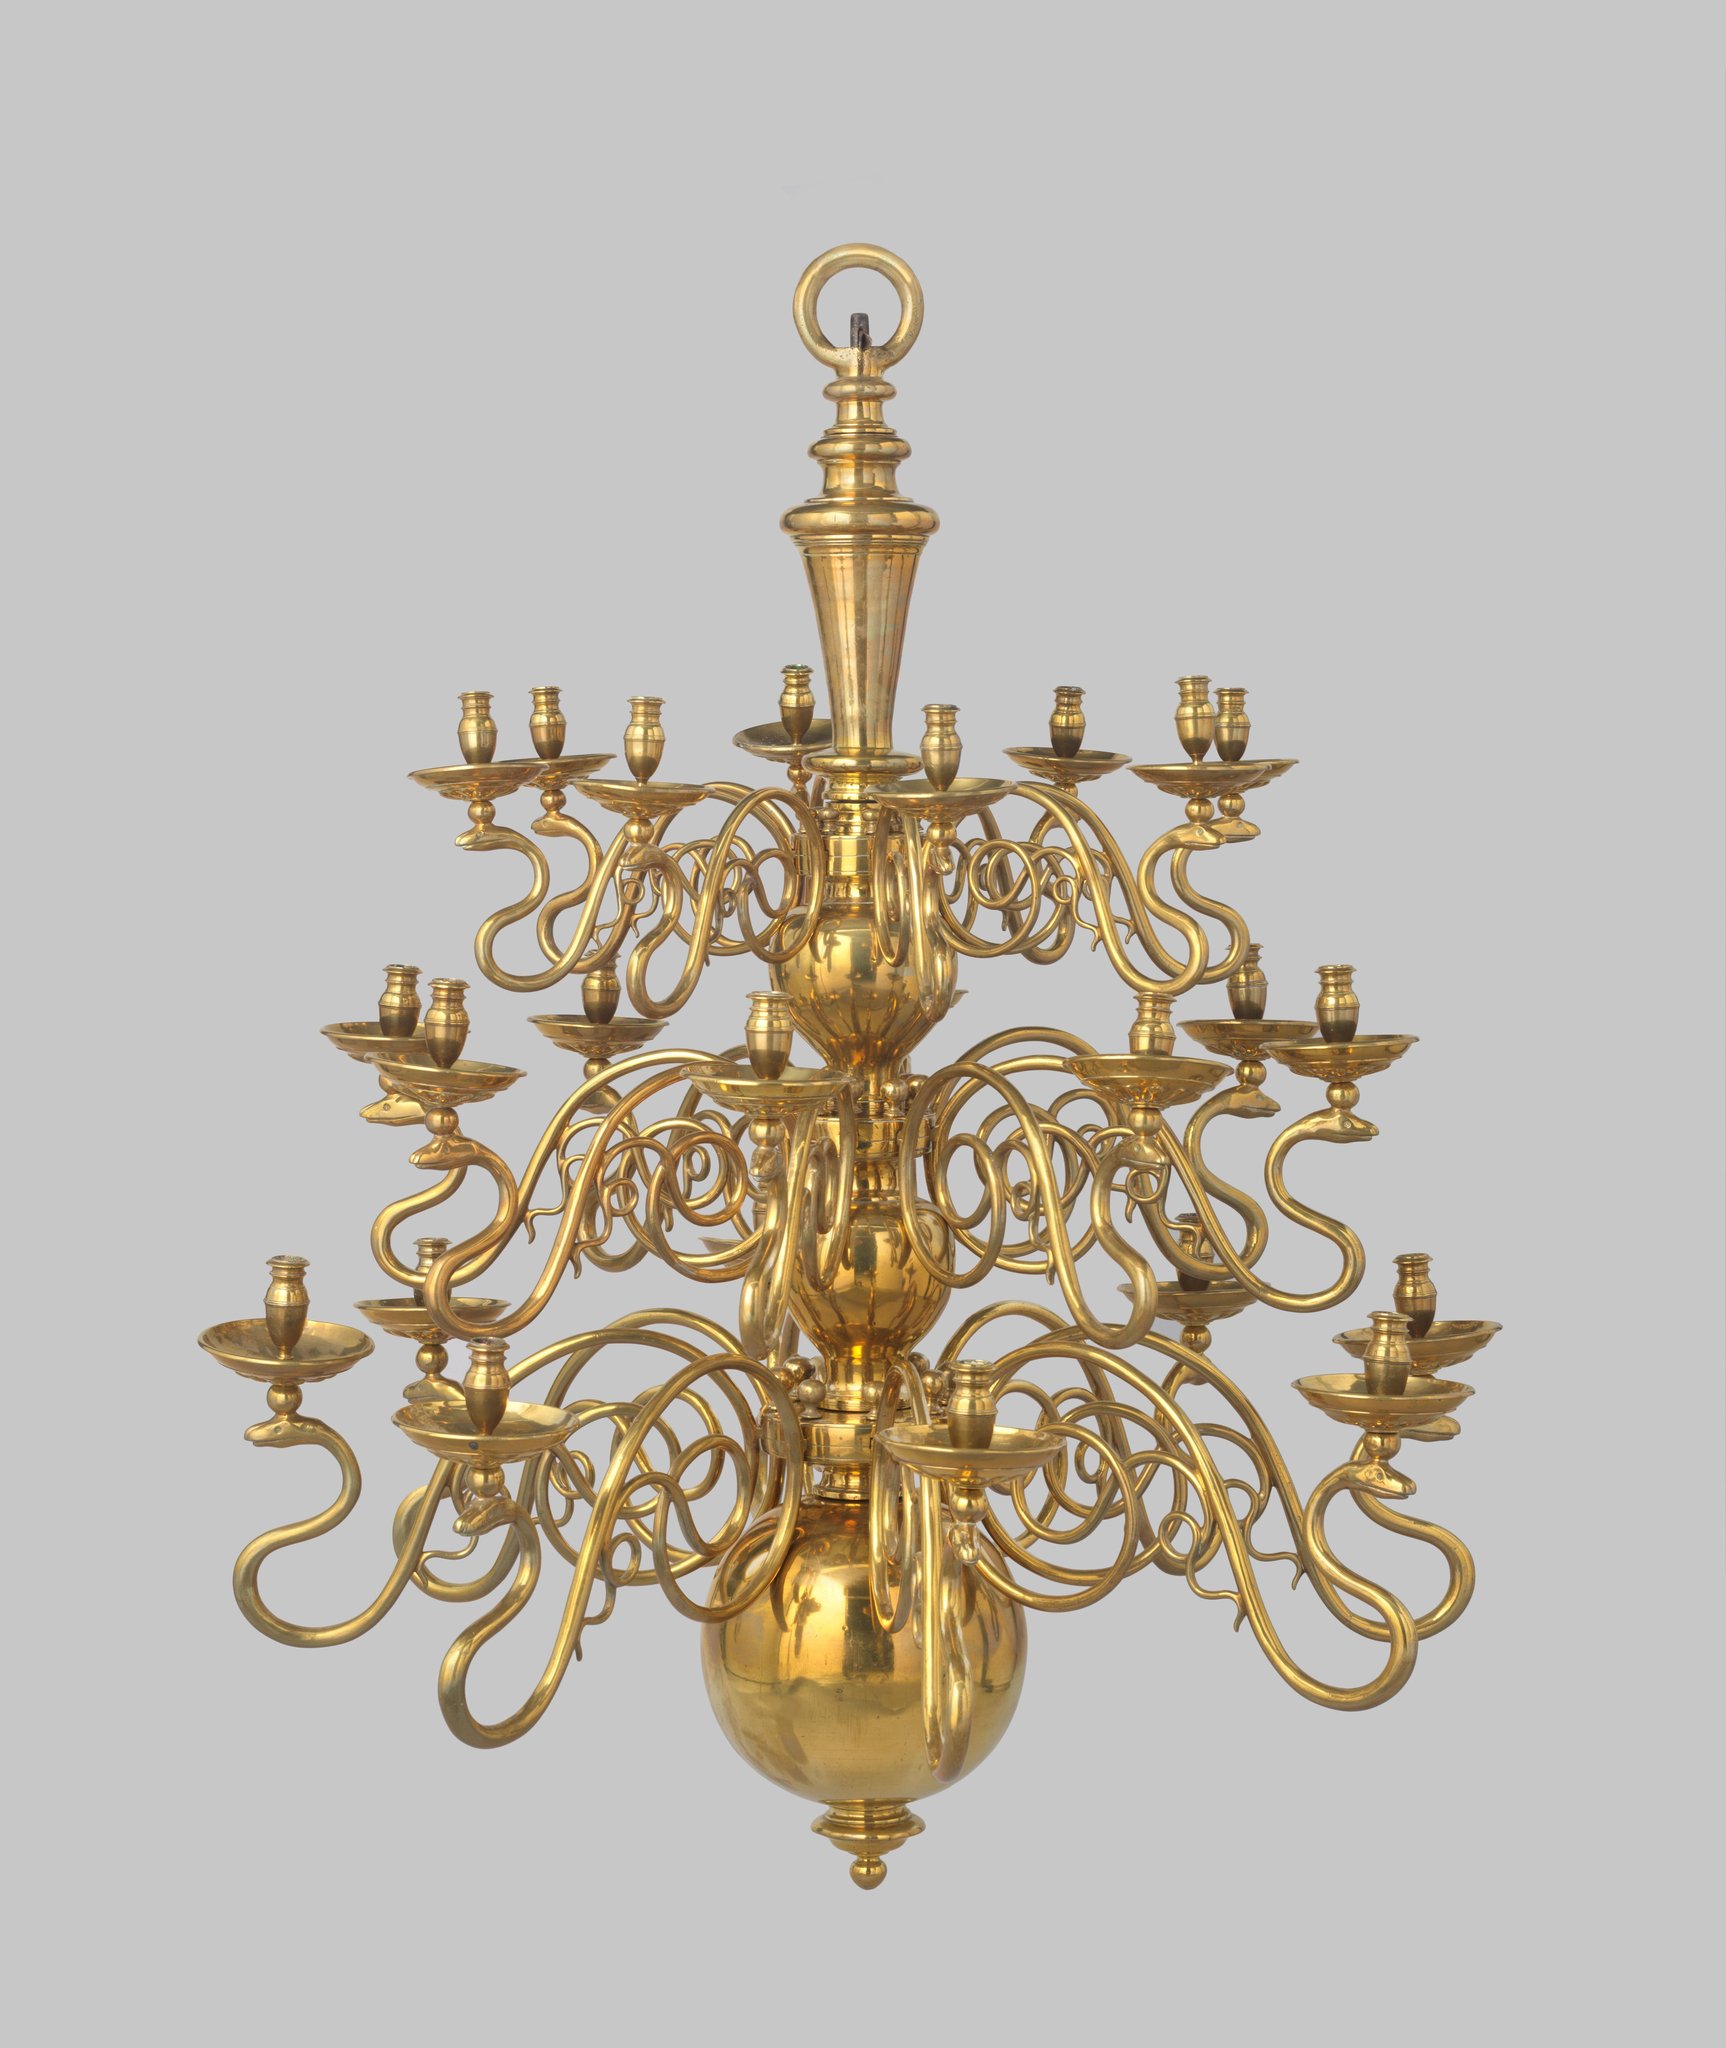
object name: chandelier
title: Kaarsenkroon van drie hoogten met ieder acht armen eindigend in een slangenkop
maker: Anonymous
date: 1625-1650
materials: brass, iron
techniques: casting, forging, screwed, turning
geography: northern netherlands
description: Candelabrum, bronze and iron. Northern Netherlands, 2nd quarter 17th century. From Protestant church in Naaldwijk. Presented by Count J.A.Z. van Rechteren Limpurg.